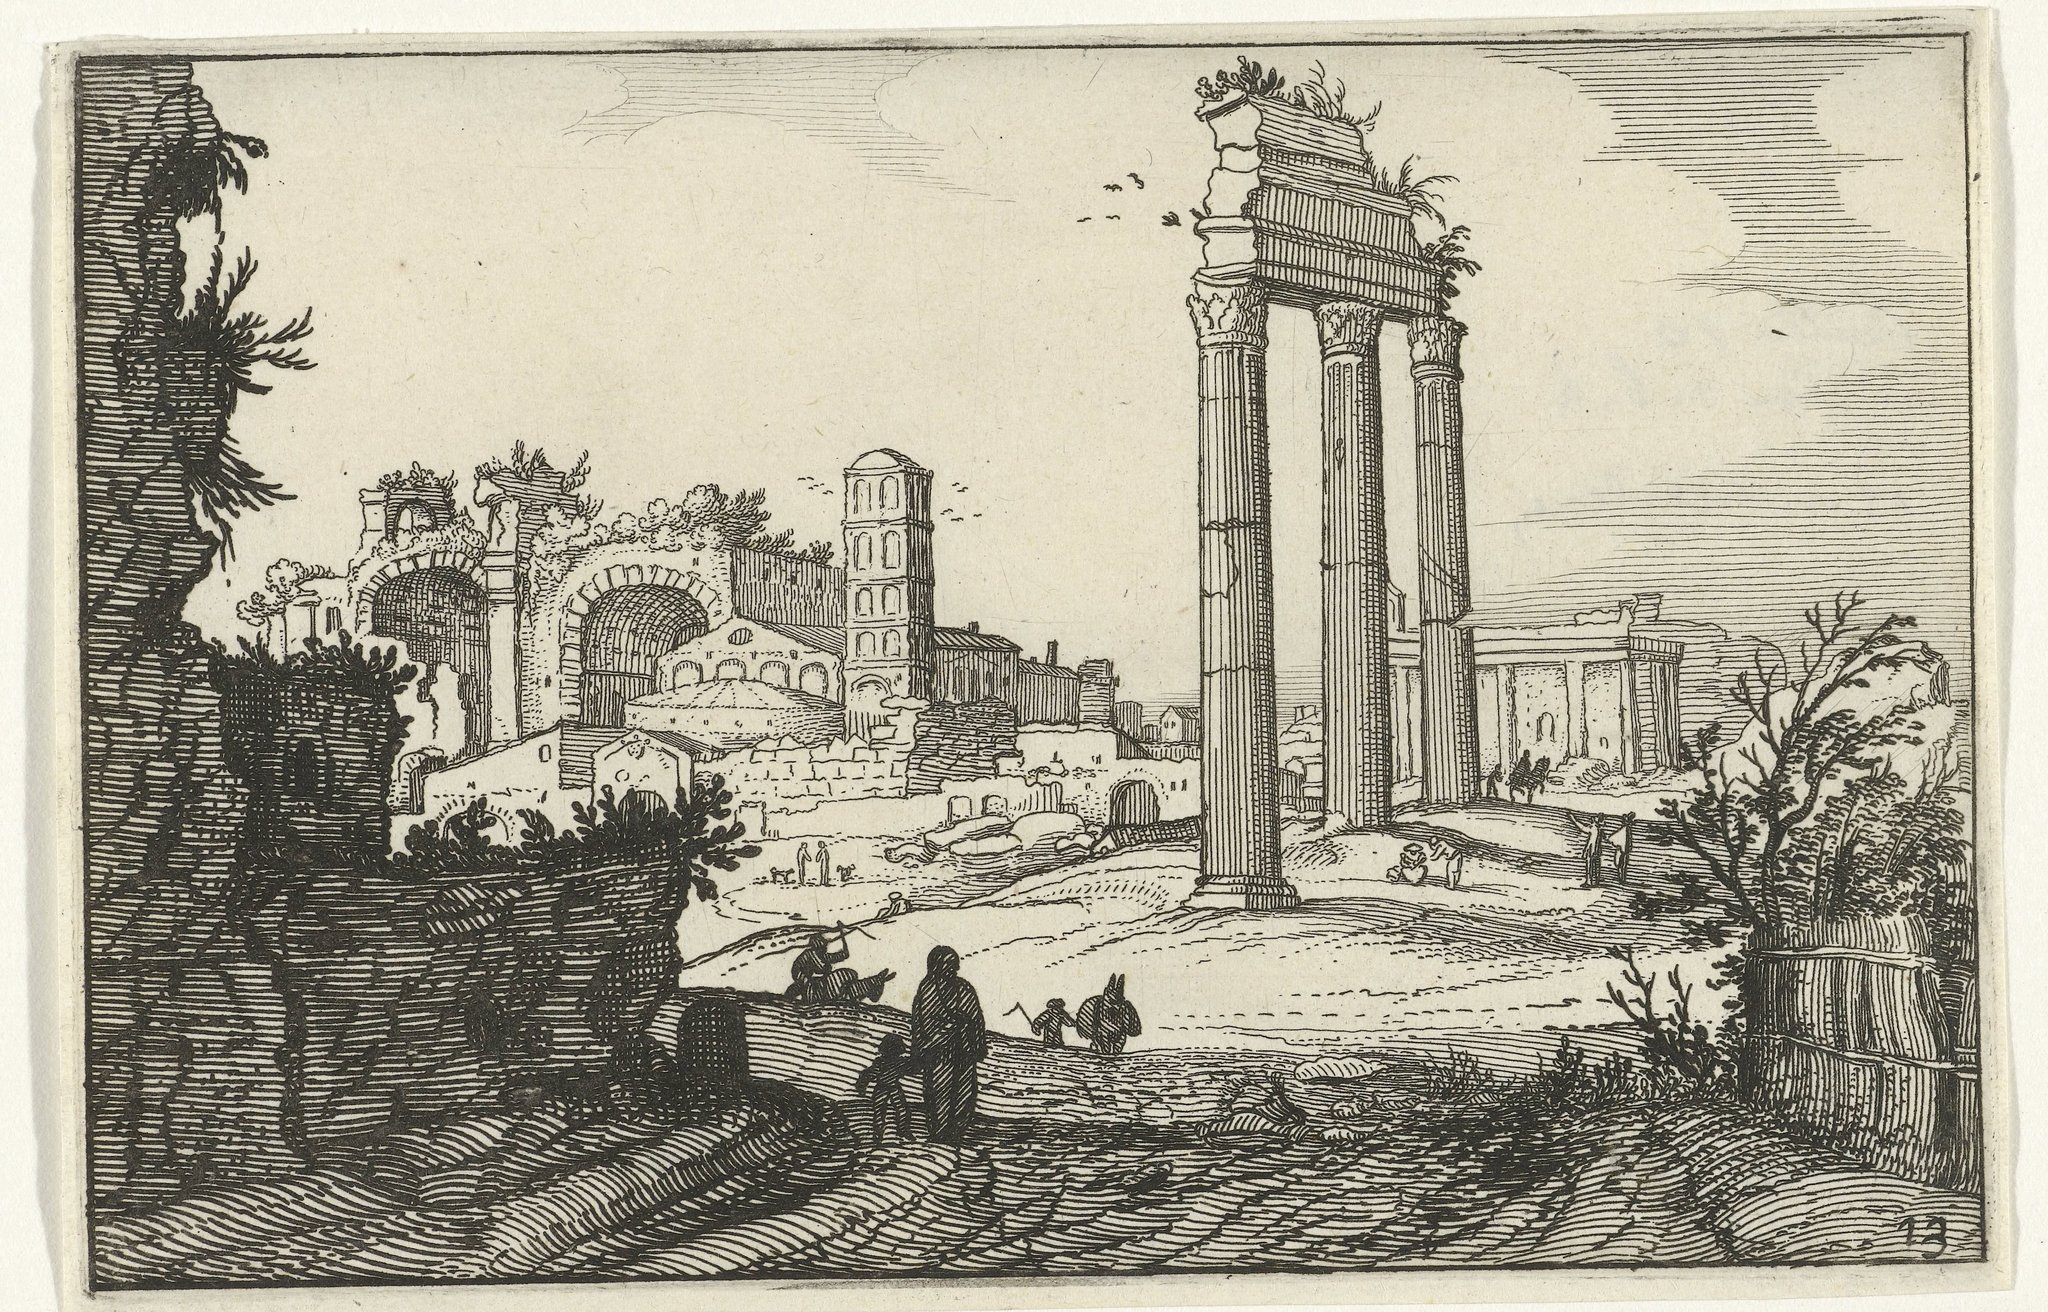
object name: print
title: Romeinse ruïnes en kustlandschappen (serie 1)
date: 1618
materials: paper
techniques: etching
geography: amsterdam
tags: ruin of a building ~ architecture, landscape with ruins, rome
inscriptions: collector's mark: Lugt 2228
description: Links de drie zuilen van de tempel van Castor en Pollux en rechts de basilica van Constantijn op het Forum Romanum in Rome. Op de voorgrond enkele figuren. Prent maakt deel uit van een serie Romeinse ruïnes en kustlandschappen naar een prentserie van Willem van Nieulandt.